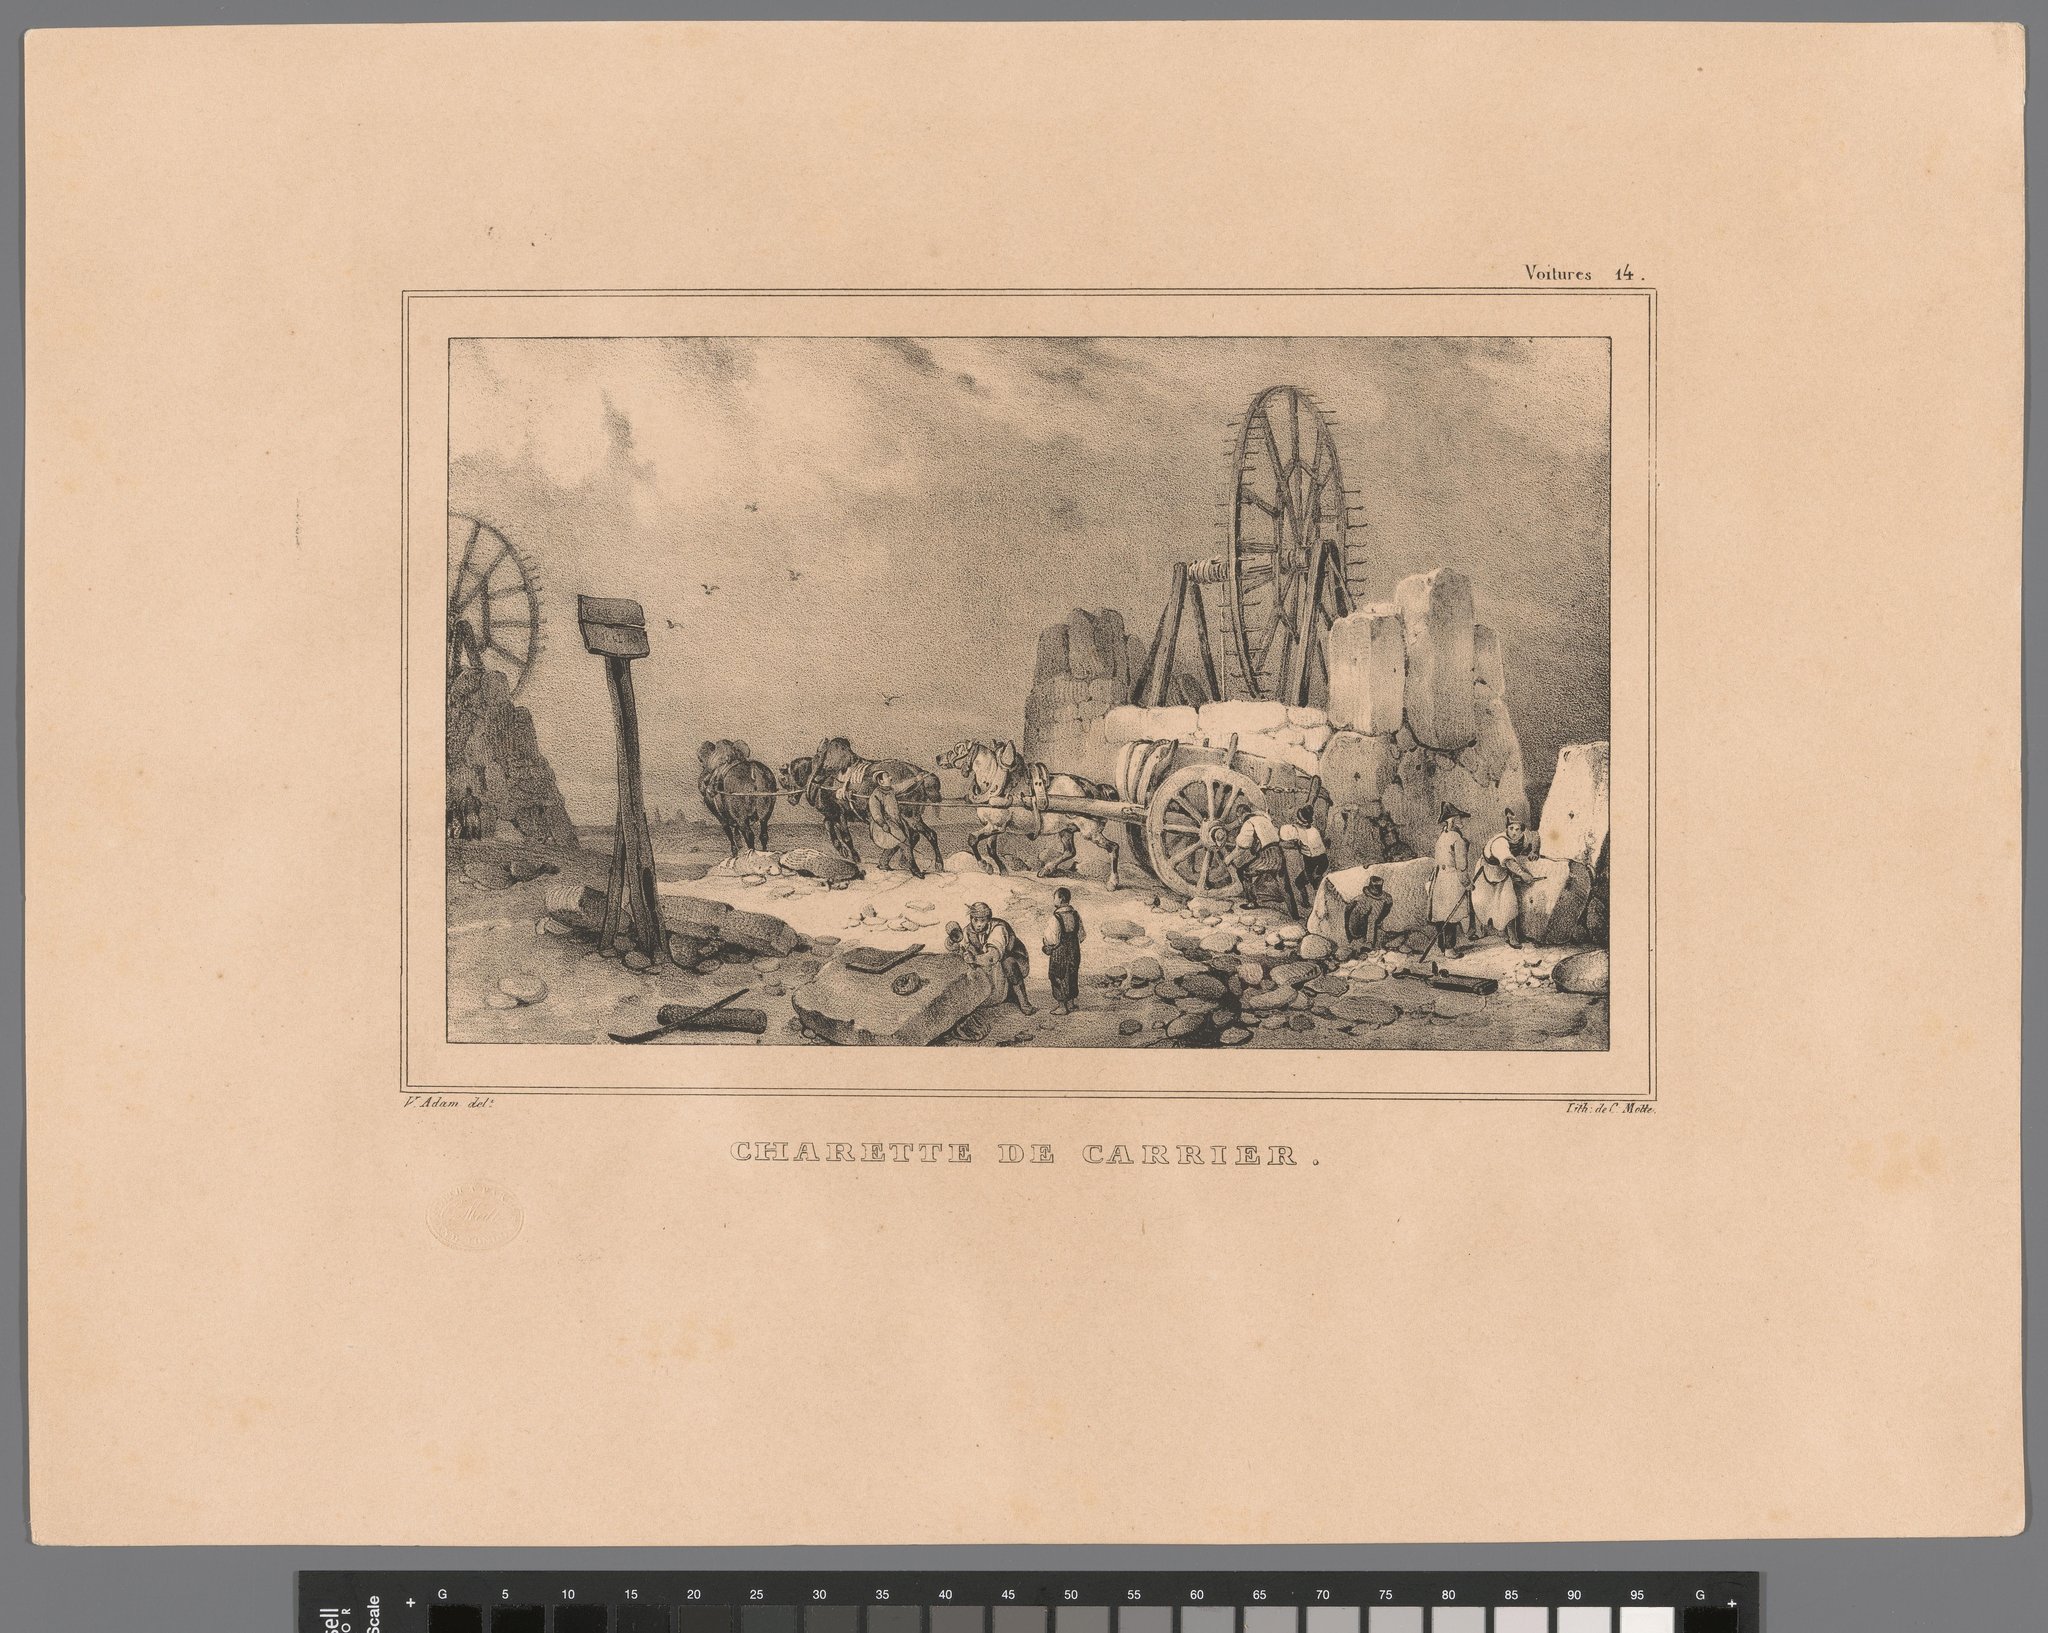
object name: print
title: Panidochème ou toutes sortes de voitures (2)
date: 1828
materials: paper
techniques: lithograph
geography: paris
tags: two-wheeled vehicle drawn by more than three animals, (farm) wagon, freight wagon, cart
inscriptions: collector's mark: Lugt 2228, stamp: Lugt 1828b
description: De prentserie waar deze prent deel van uitmaakt werd in drie delen van twaalf prenten vanaf 1827 tot en met 1830 gepubliceerd. Elk van de drie delen werd voorzien van een aparte omslag.